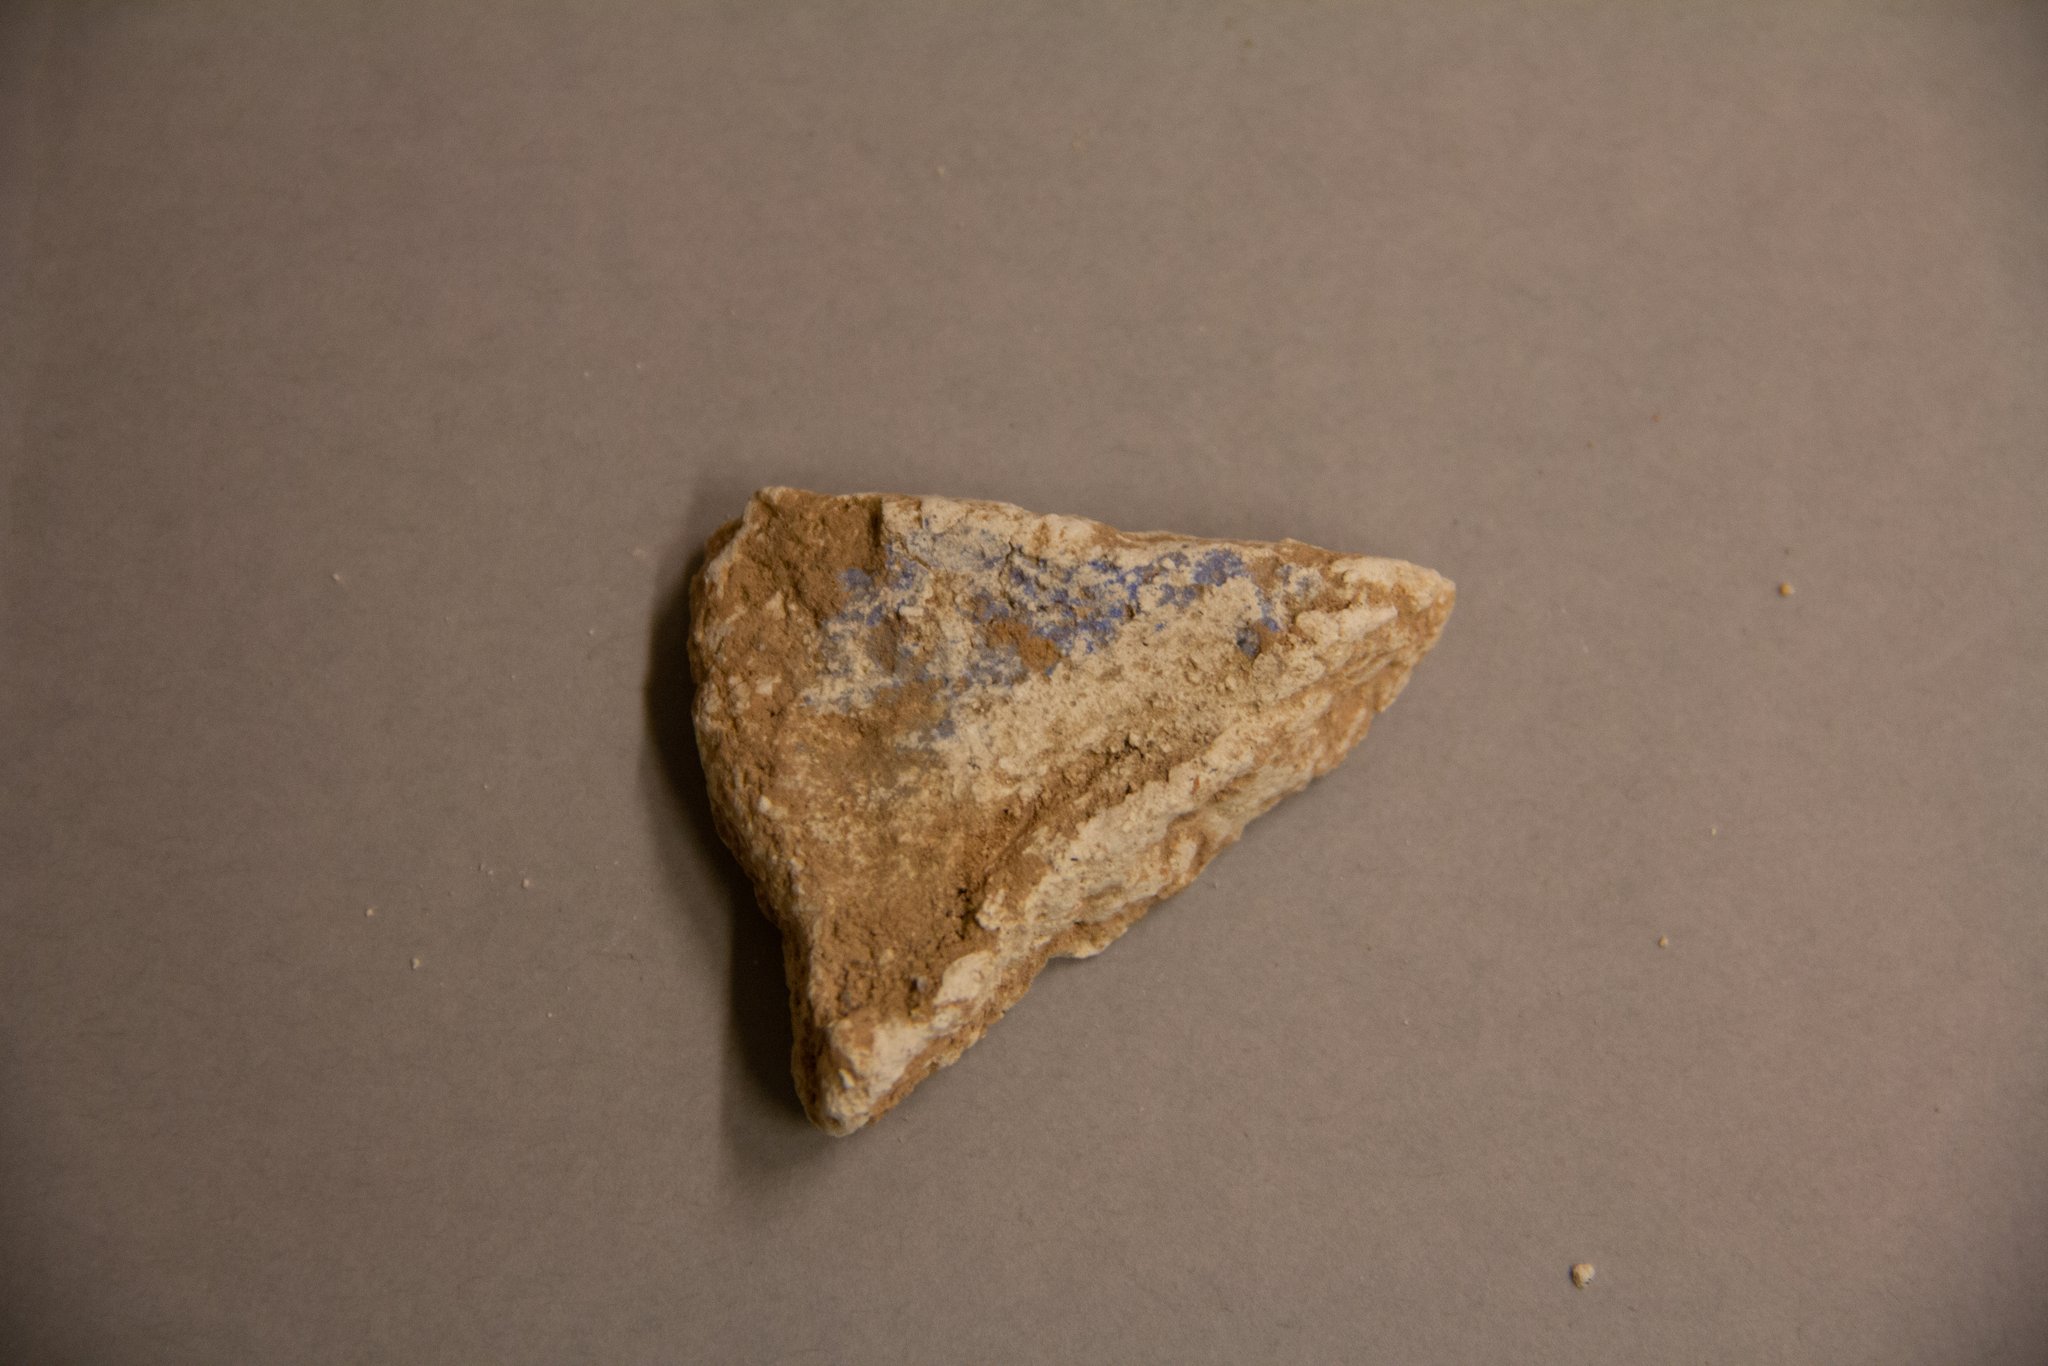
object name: fragment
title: Stucco Fragment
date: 701-1200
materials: plaster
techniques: carving, painting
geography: iran